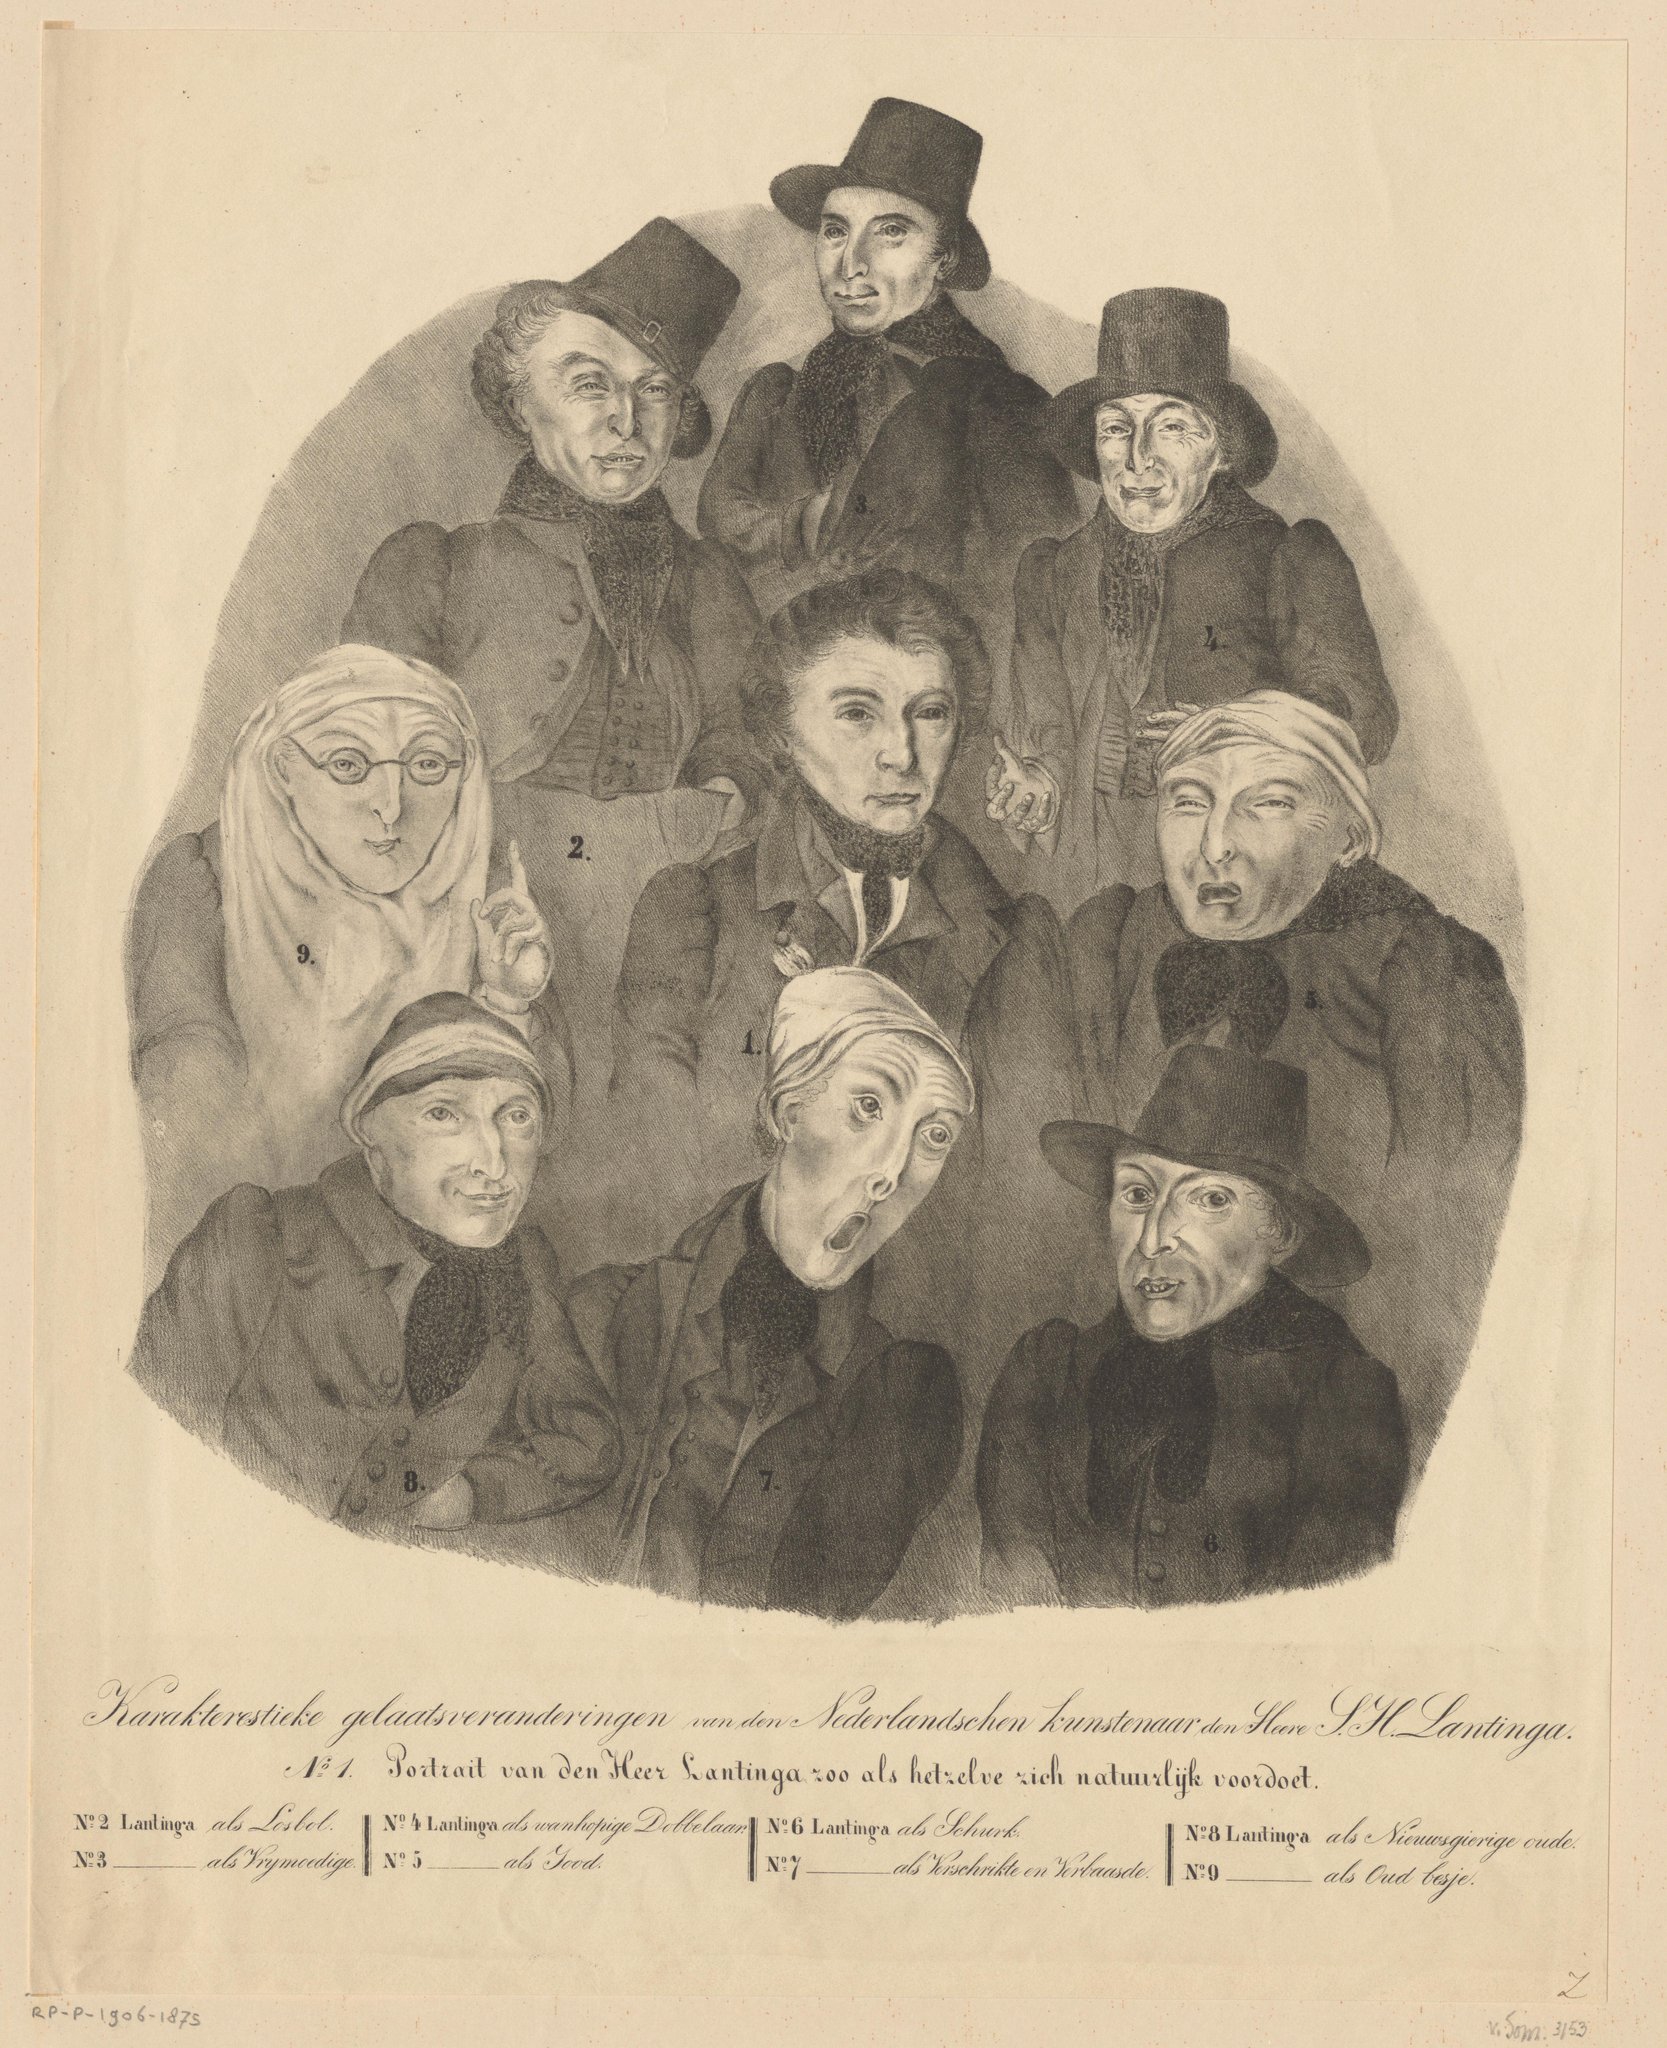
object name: print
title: Karakteristieke gelaatsveranderingen van den Nederlandsche kunstenaar den Heere Simon H. Lantinga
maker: Anonymous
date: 1835-1899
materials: paper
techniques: lithograph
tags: the arts; artists, historical persons, morphology of facial expression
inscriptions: collector's mark: Lugt 2228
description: In het midden een portret van Simon H. Lantinga 'zoo als hetzelve zich natuurlijk voordoet'. Rondom acht portretten van dezelfde kunstenaar met verschillende gelaatstrekken.